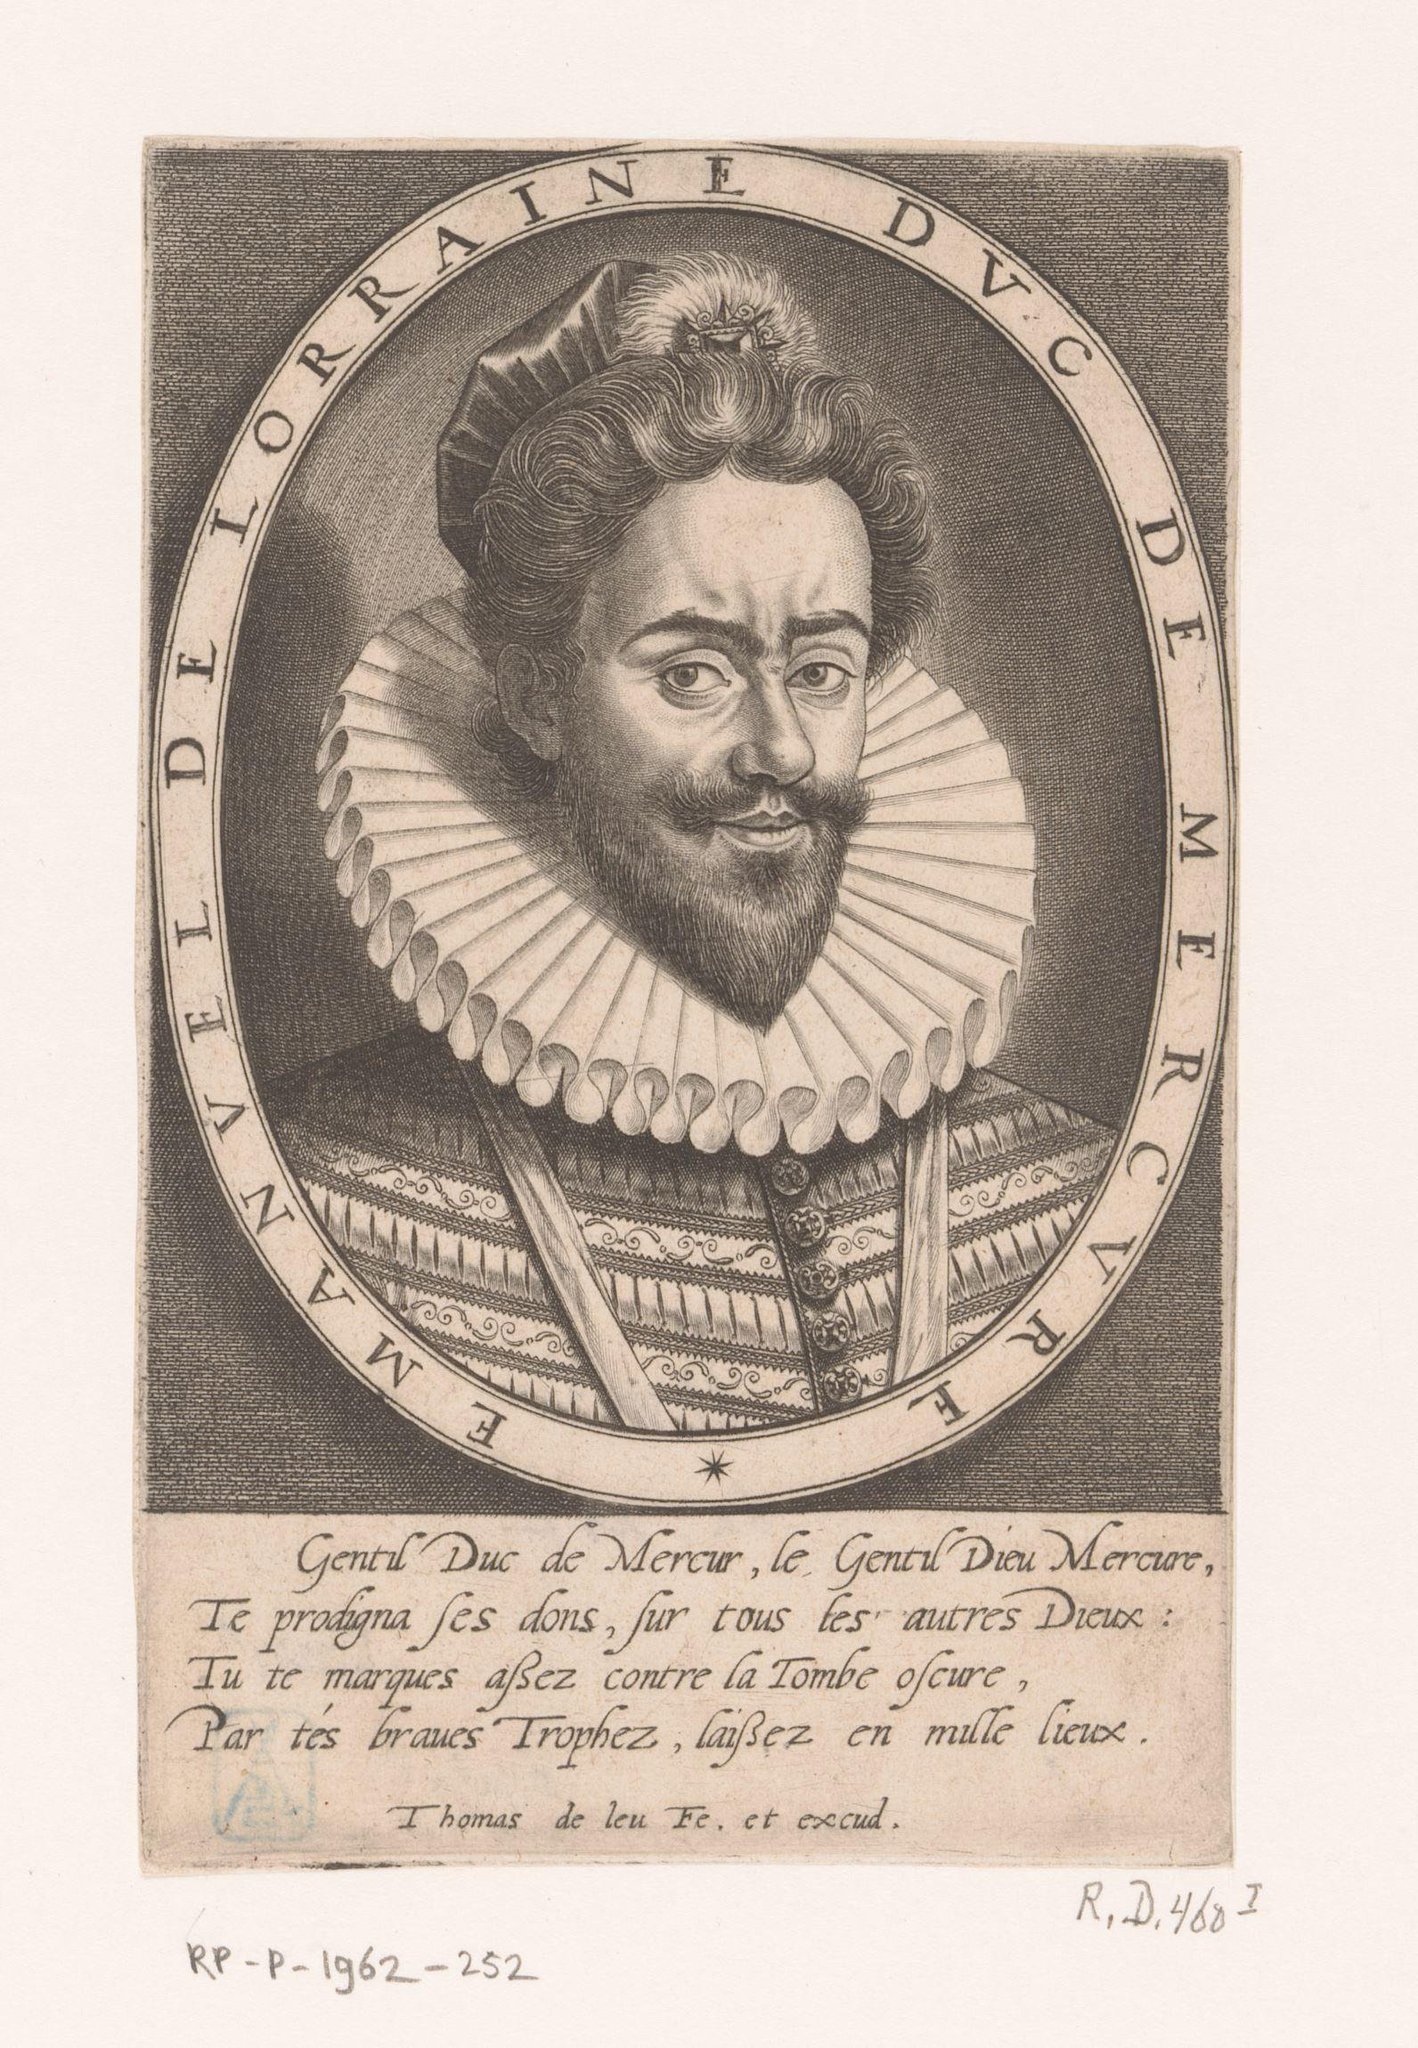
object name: print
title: Portret van Philippe-Emmanuel de Lorraine hertog van Mercoeur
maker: thomas de leu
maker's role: print maker, publisher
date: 1576-1614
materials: paper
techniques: engraving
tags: historical persons, neck-gear: collar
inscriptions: collector's mark: Lugt 2351c, collector's mark: Lugt 2228, collector's mark: Lugt 2760